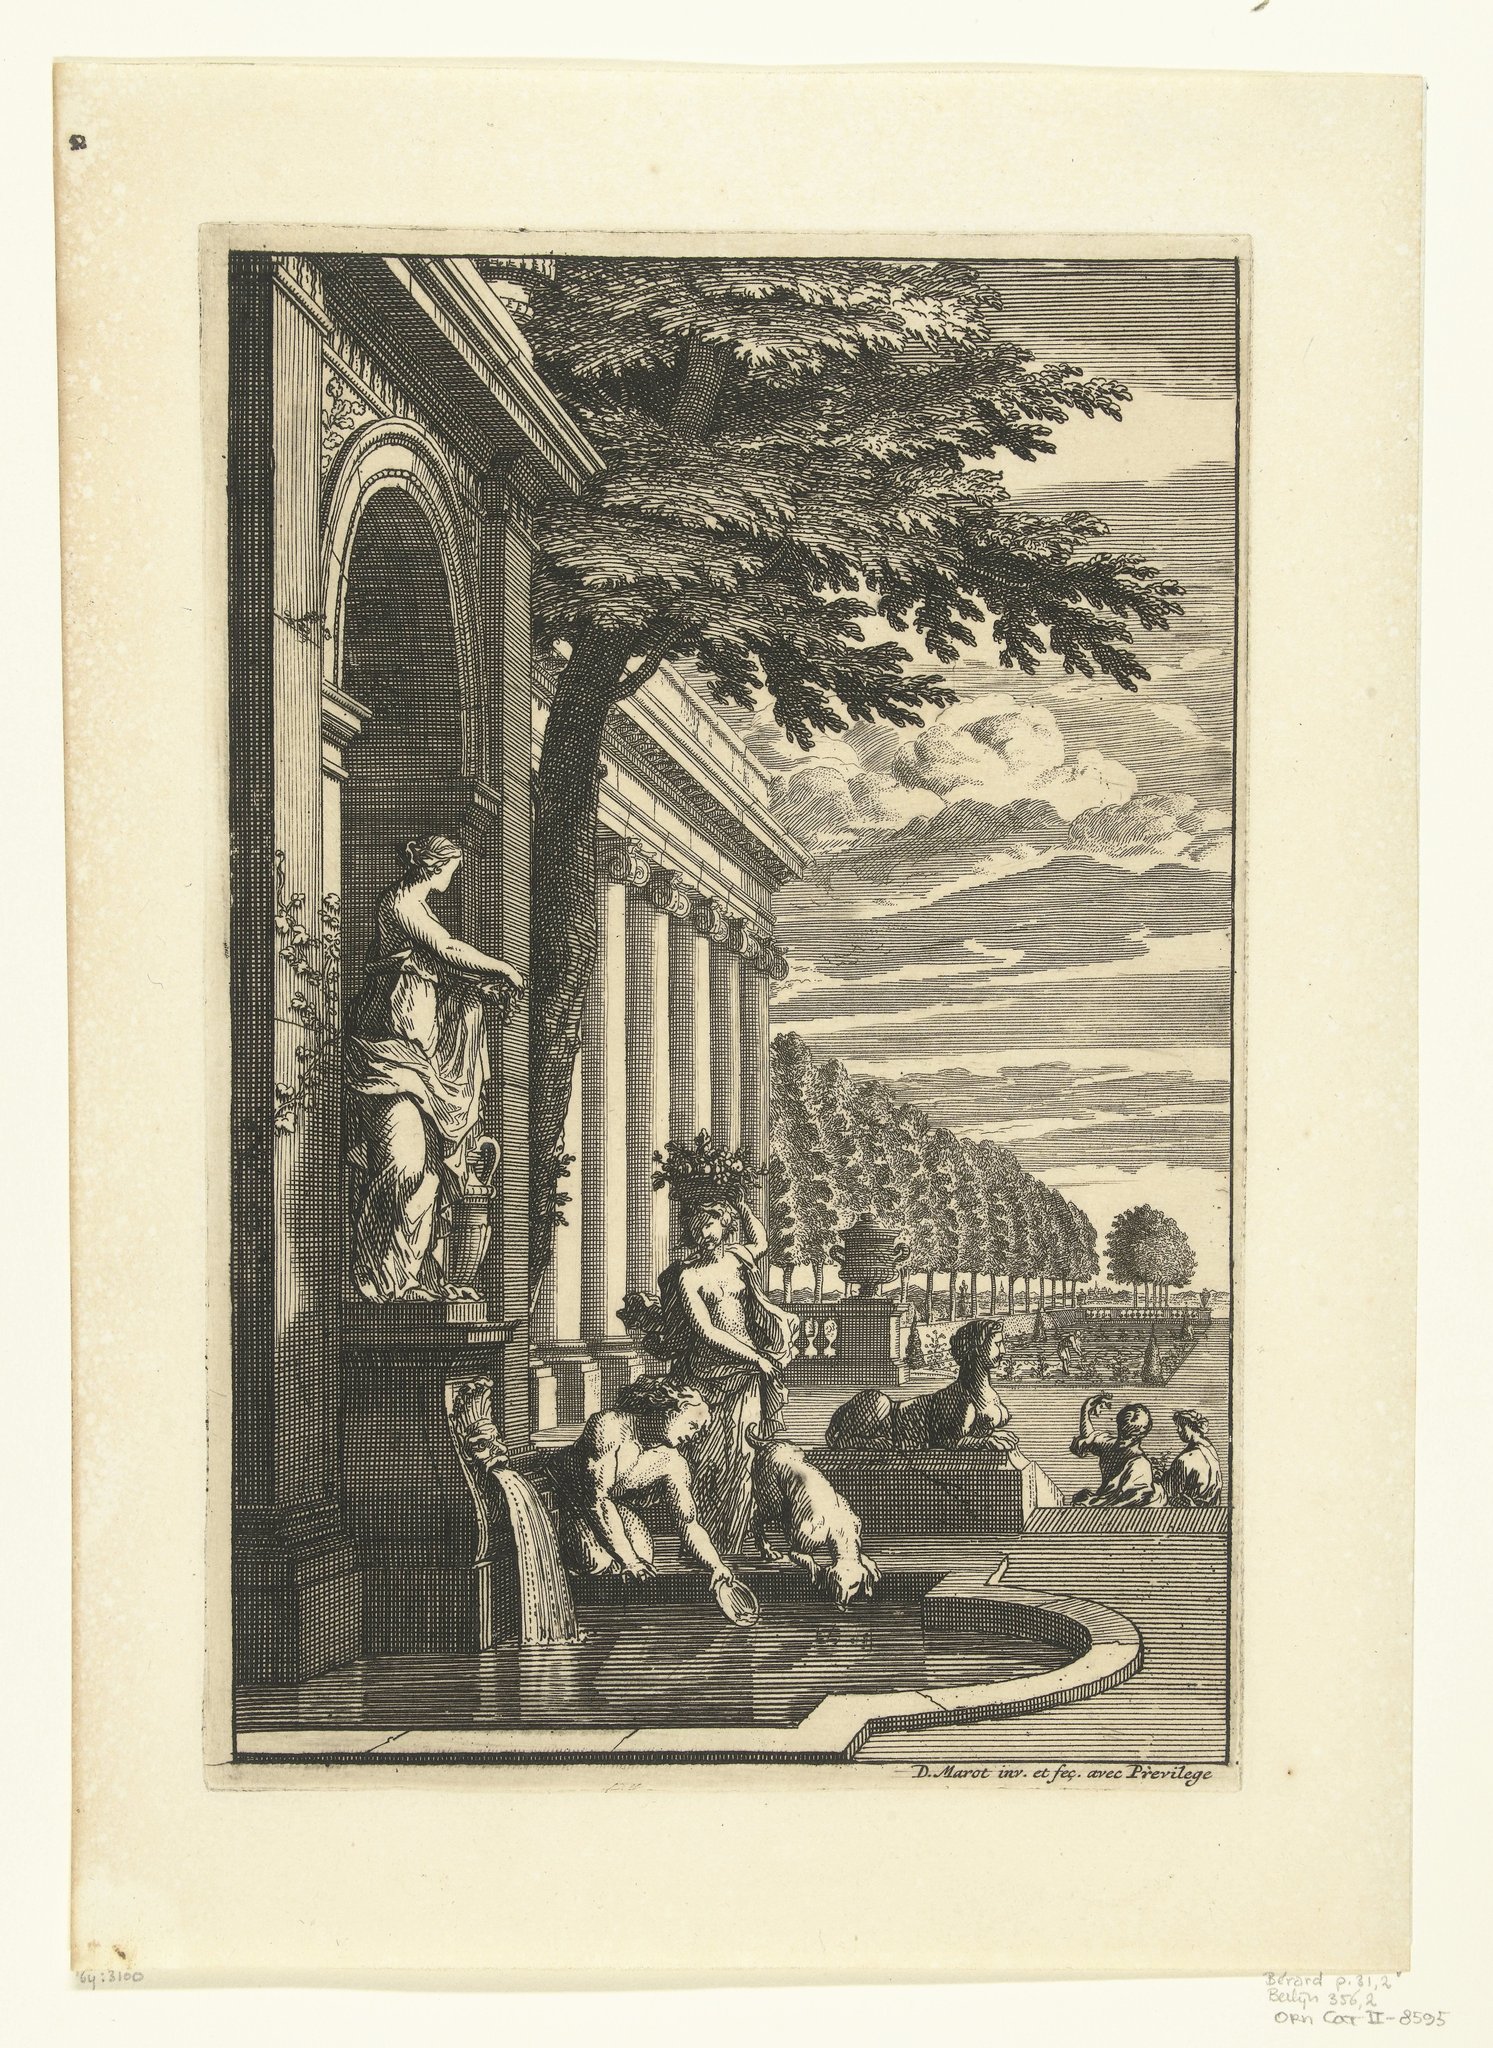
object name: ornament print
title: Nis met standbeeld en bassin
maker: daniël marot (i)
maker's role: draughtsman, print maker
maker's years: 1661-1752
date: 1703-1712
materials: paper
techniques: etching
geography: netherlands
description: Een man schept water uit het bassin. Op de achtergrond is een gebouw met Ionische zuilen zichtbaar. Uit serie van 6 bladen.